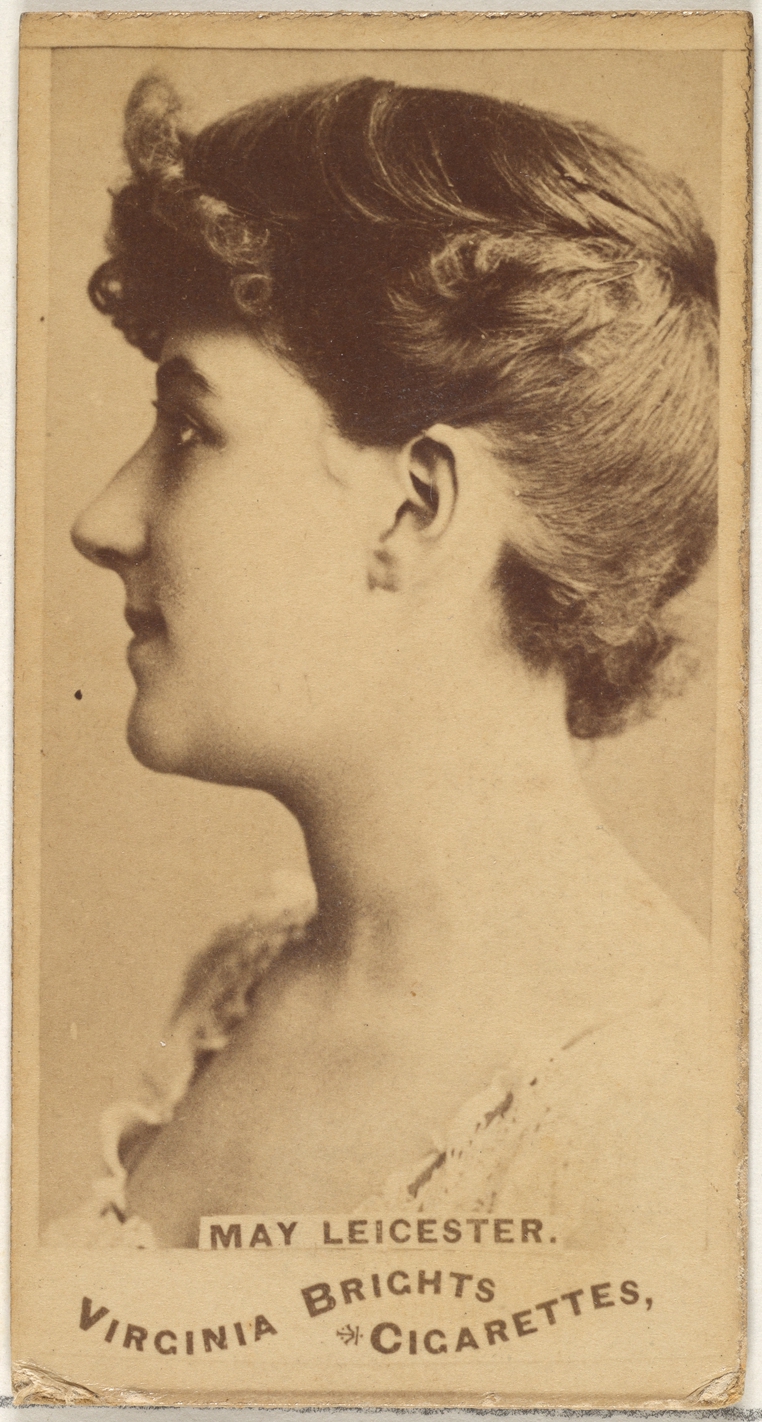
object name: photograph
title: May Leicester, from the Actors and Actresses series (N45, Type 1) for Virginia Brights Cigarettes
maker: allen & ginter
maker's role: publisher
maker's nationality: american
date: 1888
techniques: albumen silver print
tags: portraits,profiles,women,actresses